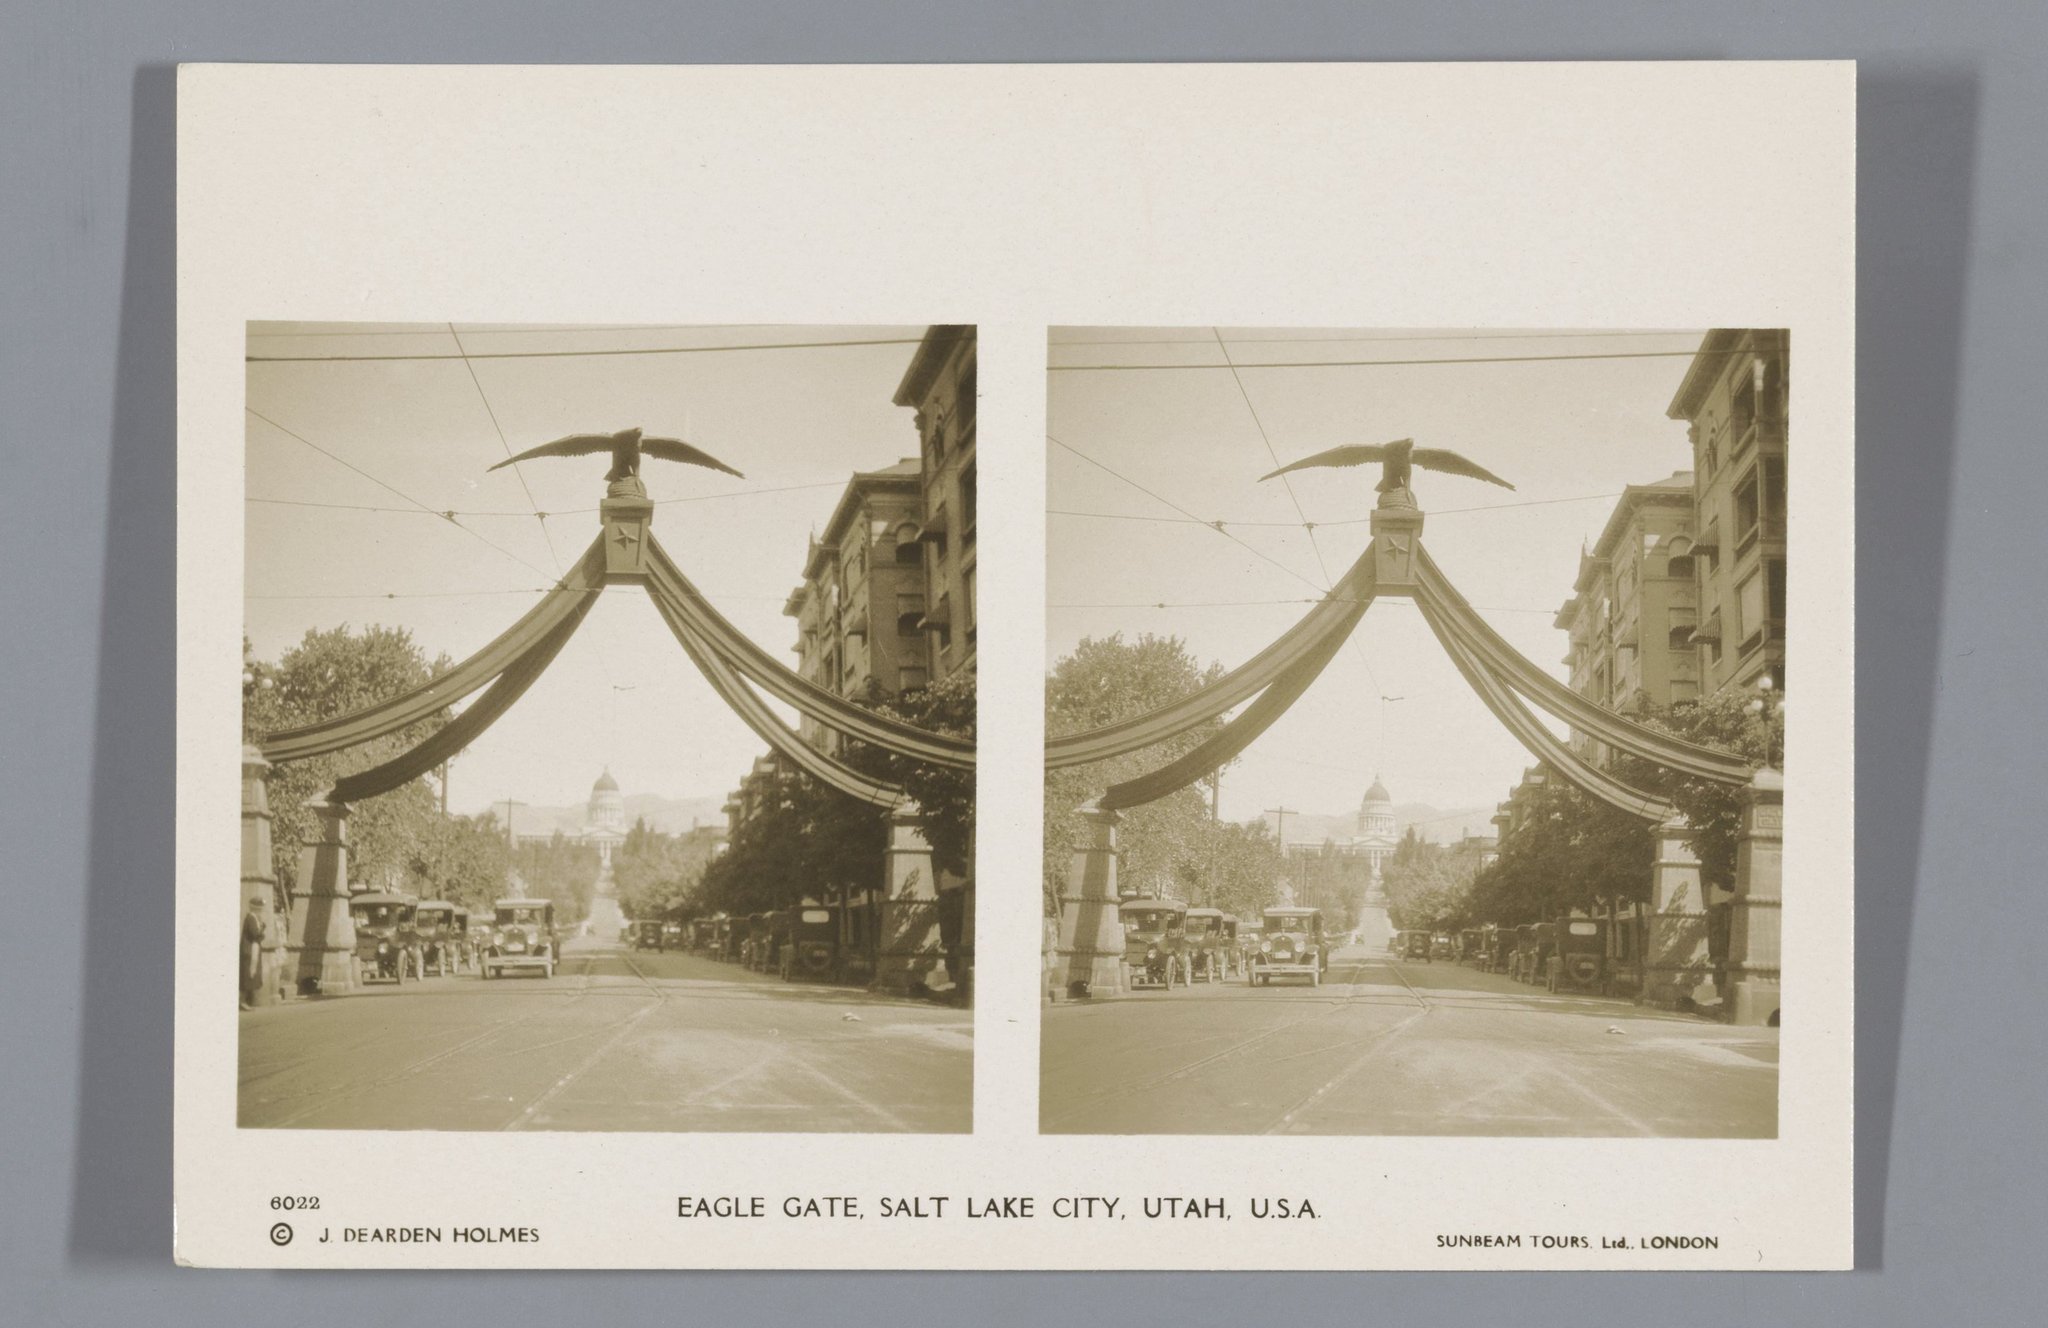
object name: stereograph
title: Eagle Gate, Salt Lake City, Utah, U.S.A.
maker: james dearden holmes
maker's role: fotograaf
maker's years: 1873-1937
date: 1924-1926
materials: paper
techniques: gelatin silver print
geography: salt lake city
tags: gate, entrance, symbols of particular nations, states, districts, etc., predatory birds: eagle (+ animals used symbolically)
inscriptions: number: ‘6022’